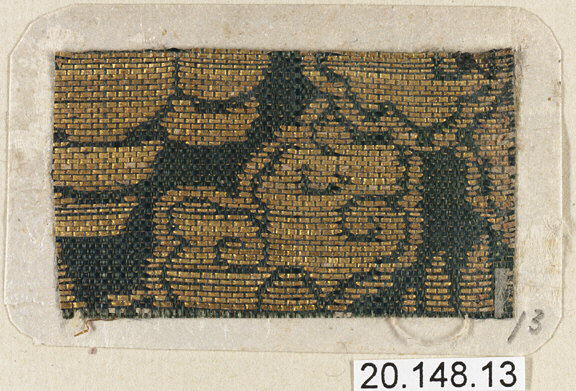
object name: piece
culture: japanese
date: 1301-1400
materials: silk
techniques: compound weave